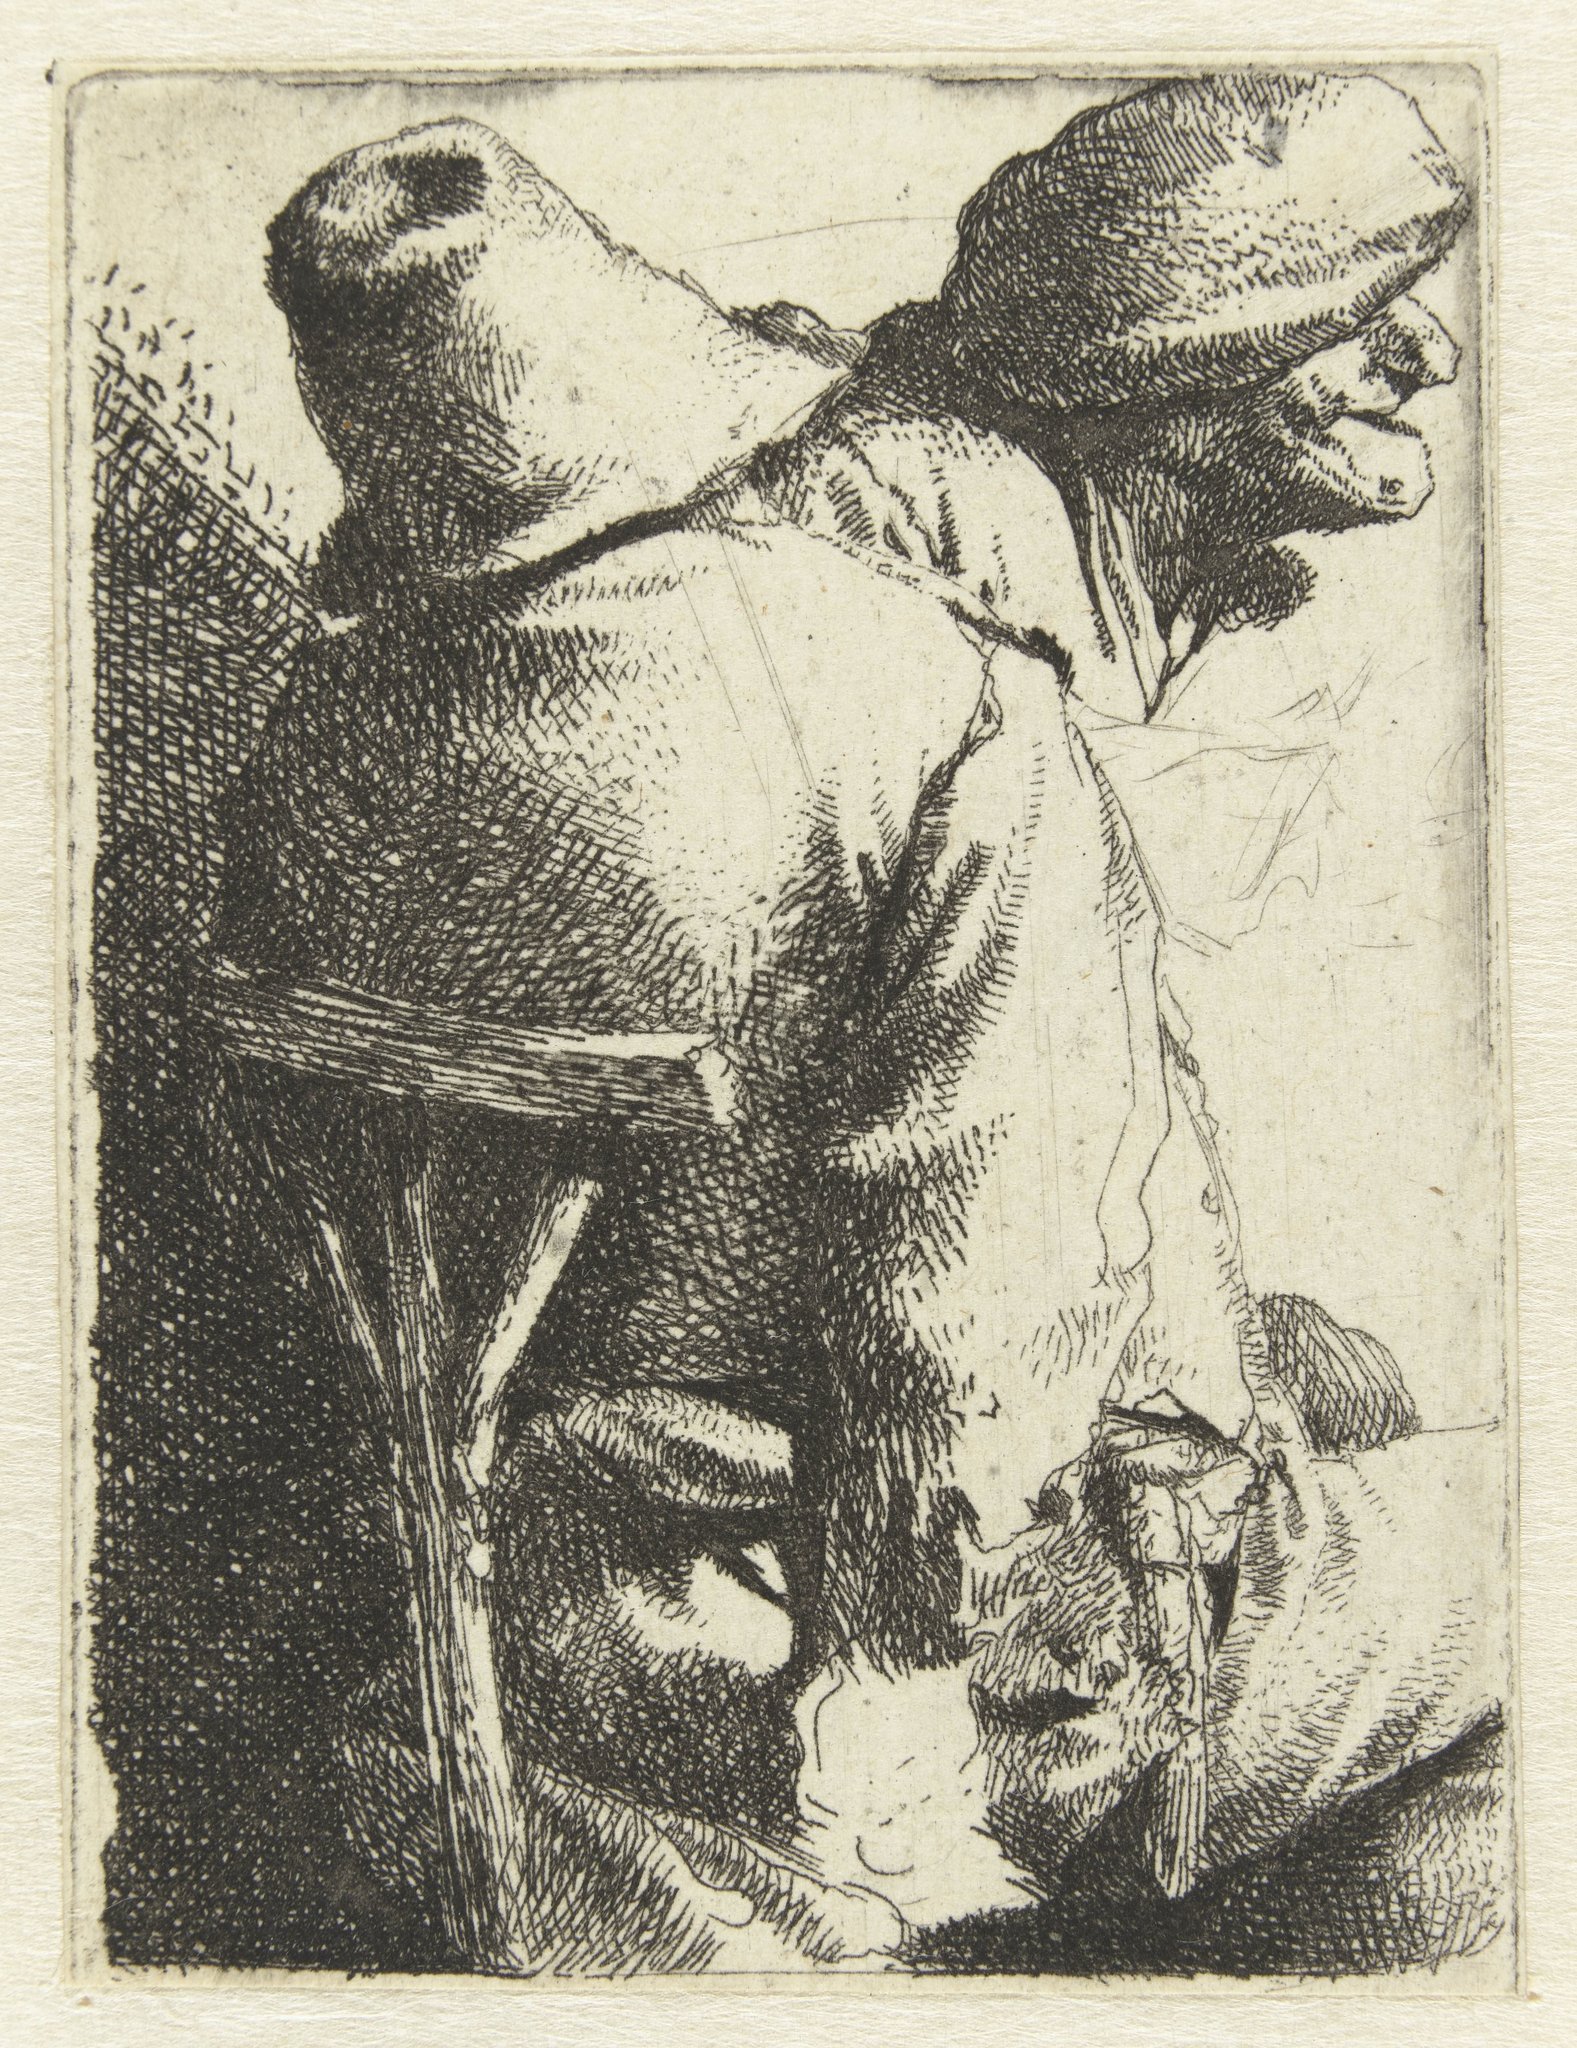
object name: print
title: Man zittend op rug gezien, vrouwen- of mannenhoofd met muts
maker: cornelis pietersz. bega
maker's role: draughtsman, painter, print maker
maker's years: 1631-1664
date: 1642-1664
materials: paper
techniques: etching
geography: netherlands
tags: female sex; woman, head-gear: cap (+ men's clothes), male sex; man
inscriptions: collector's mark: Lugt 240